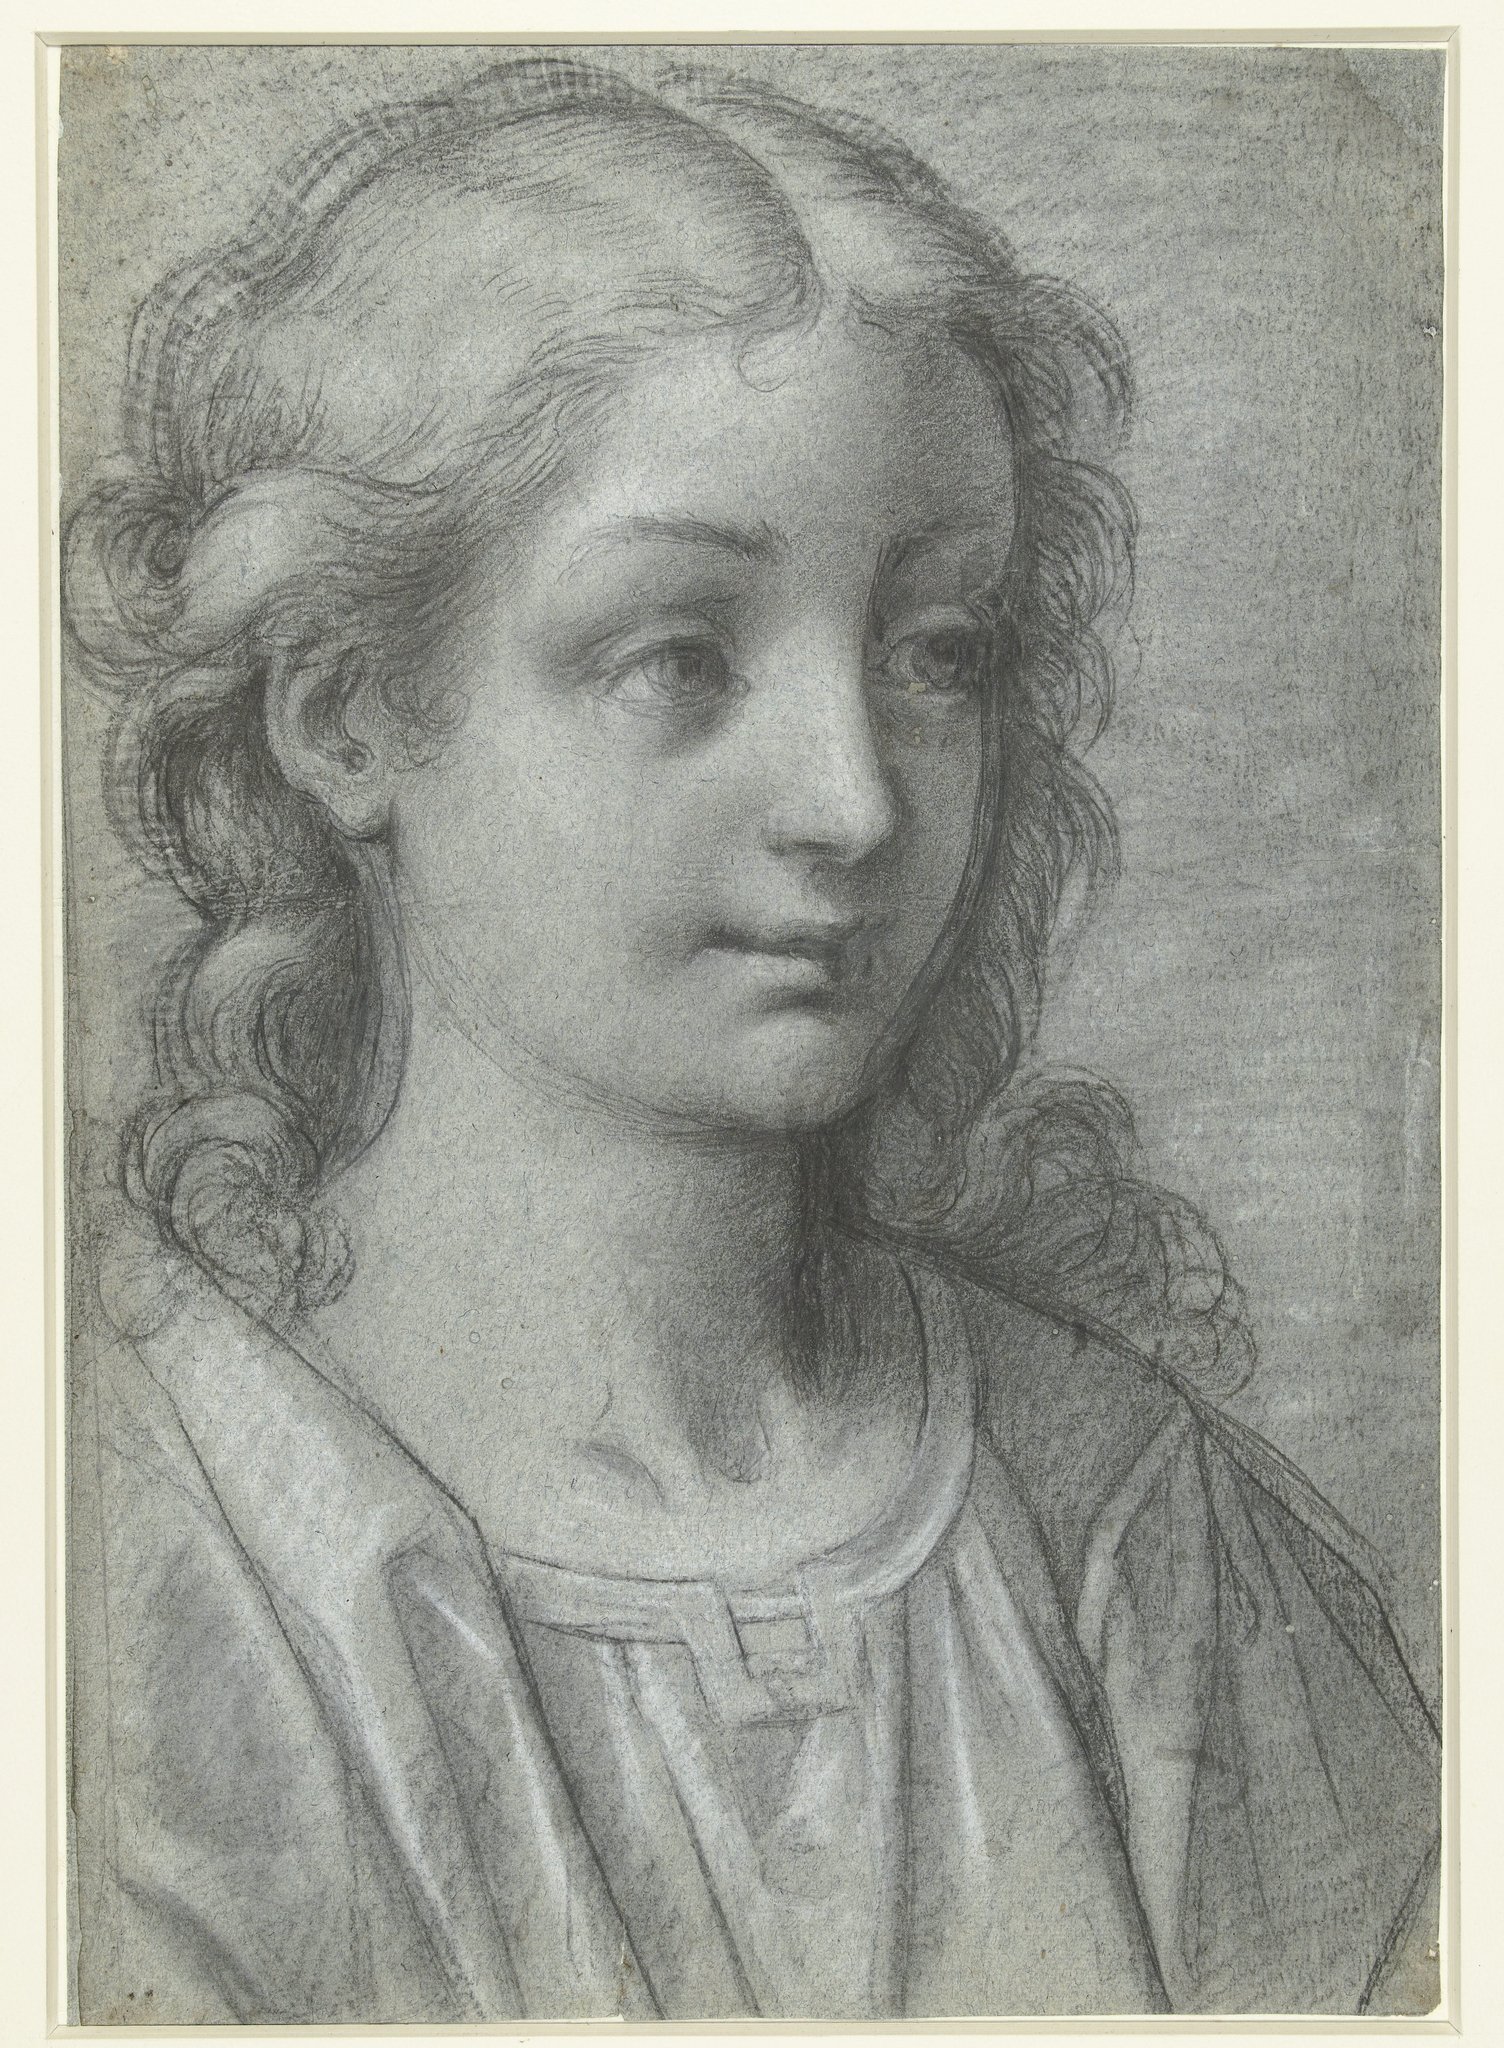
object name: drawing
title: Hoofd van een jong meisje met krullend haar en stralenkrans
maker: Anonymous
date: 1600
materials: chalk, paper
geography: rome